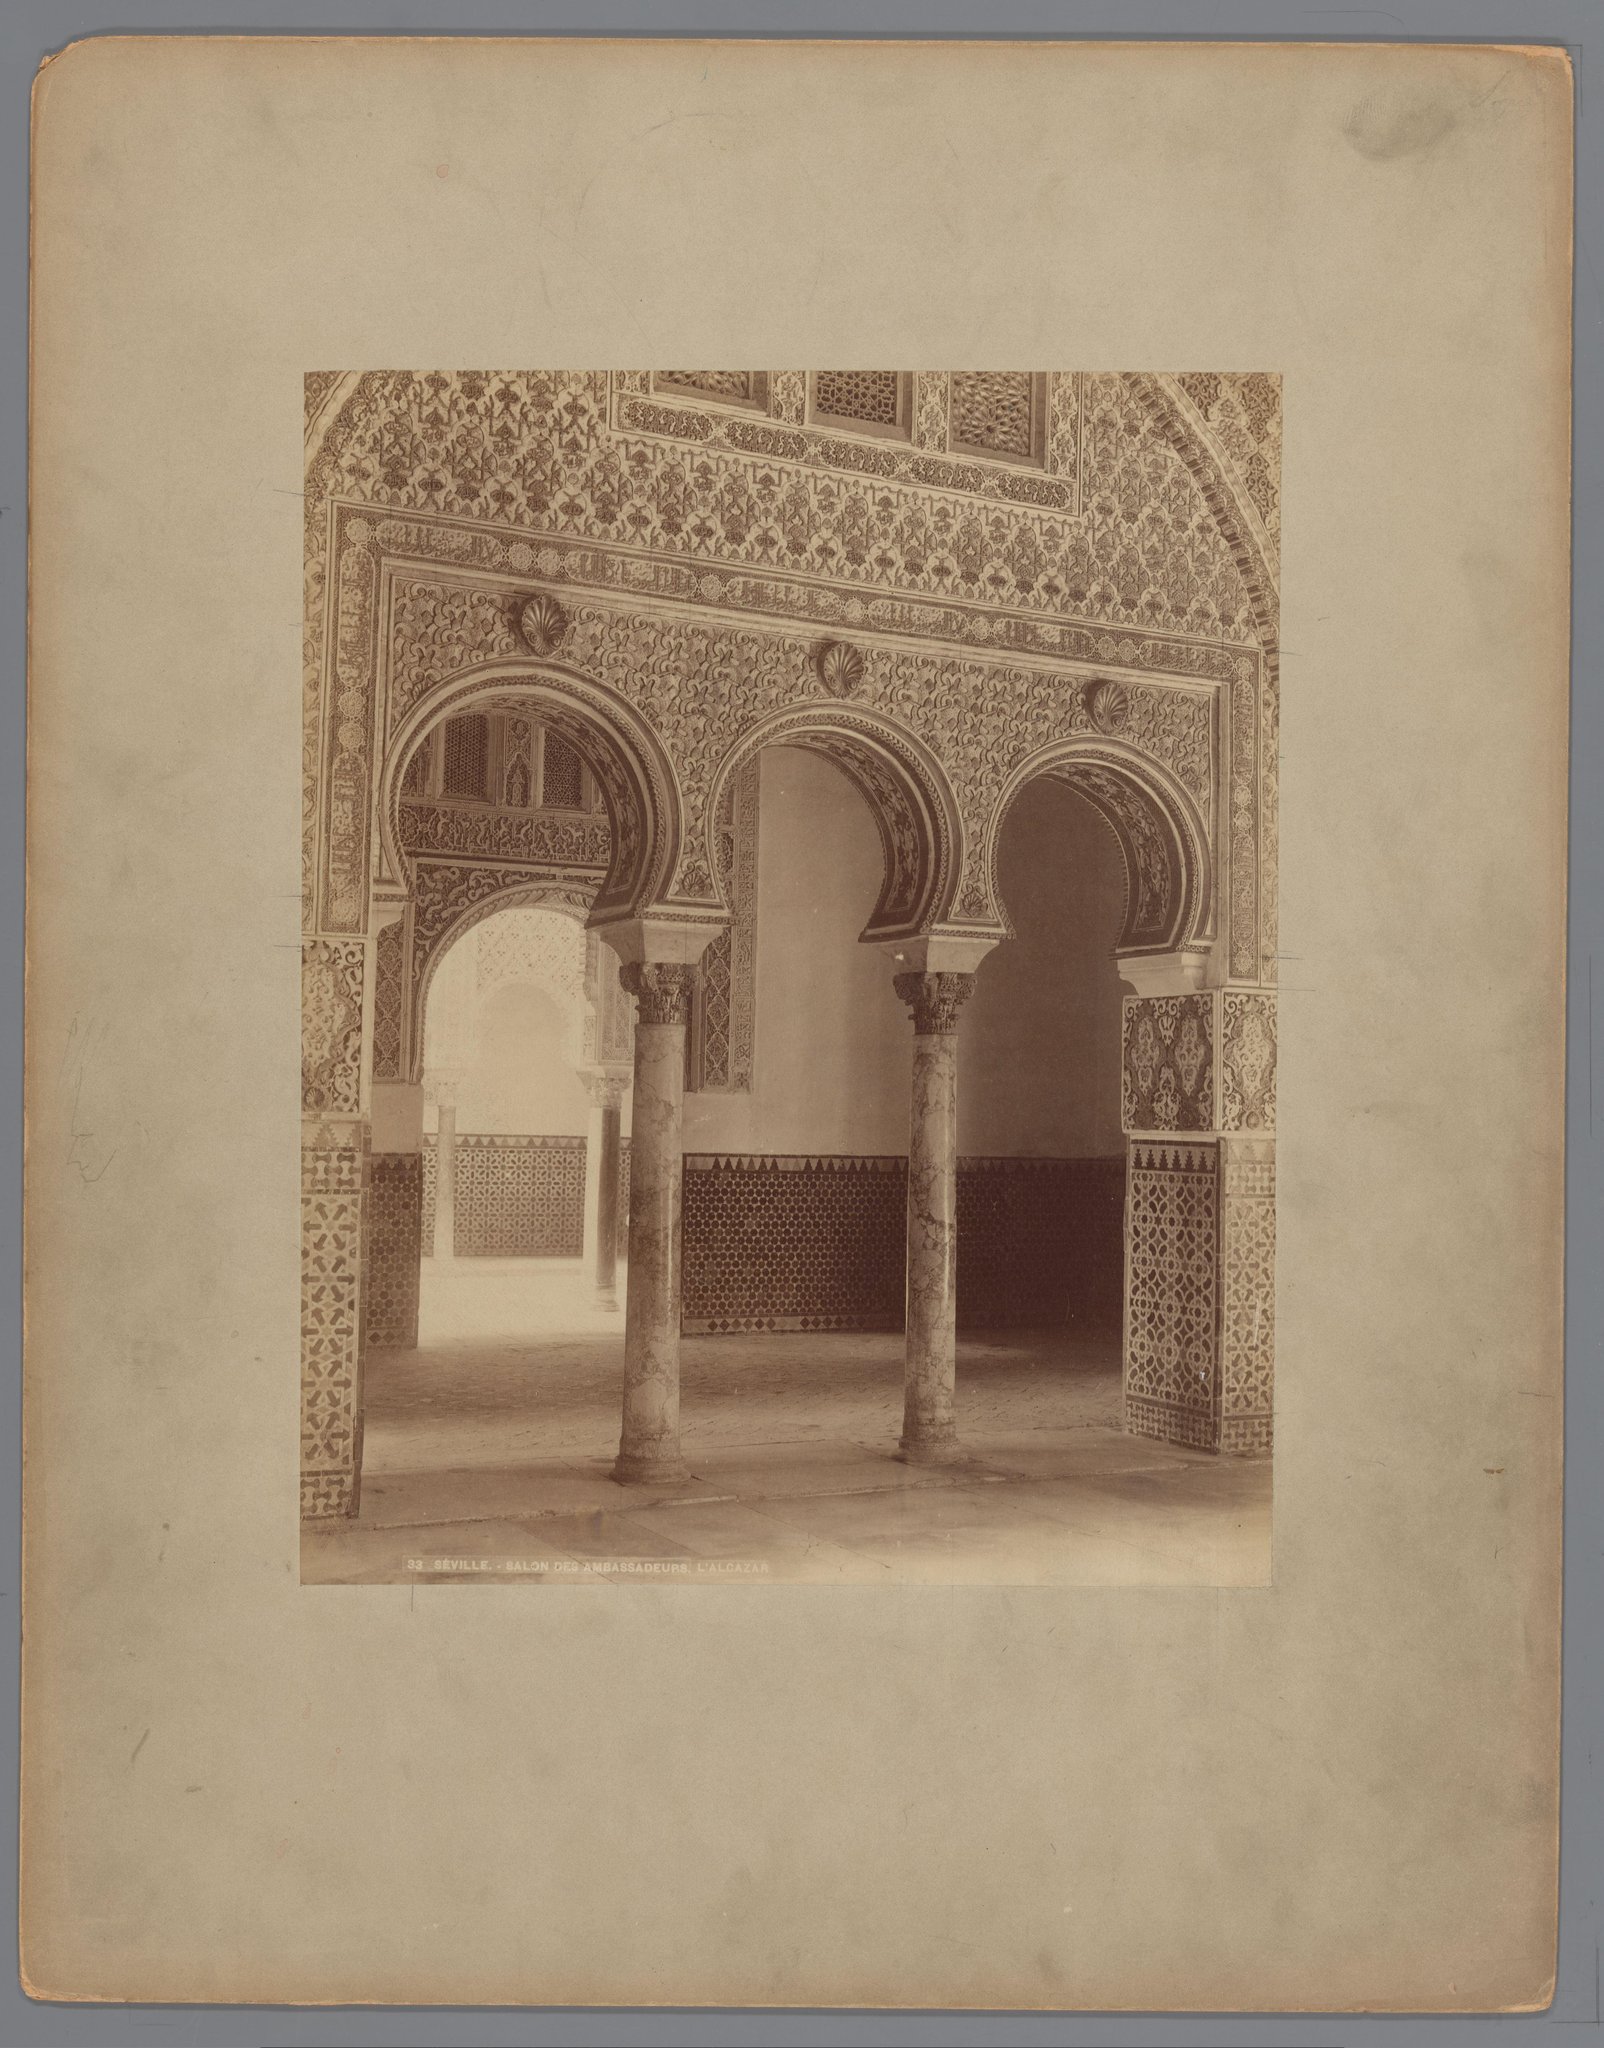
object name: photograph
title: Zuilen in de Zaal van de Ambassadeurs in het Koninklijk Paleis van Sevilla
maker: Anonymous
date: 1875-1900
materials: cardboard, photographic support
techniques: albumen print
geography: royal palace of seville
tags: column, pillar ~ architecture, flat decoration ~ applied arts (+ islamic art), palace, interior ~ representation of a building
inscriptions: collector's mark: Lugt 3937, number: ‘33’, inscription: ‘Syrië’, inscription:, annotation: